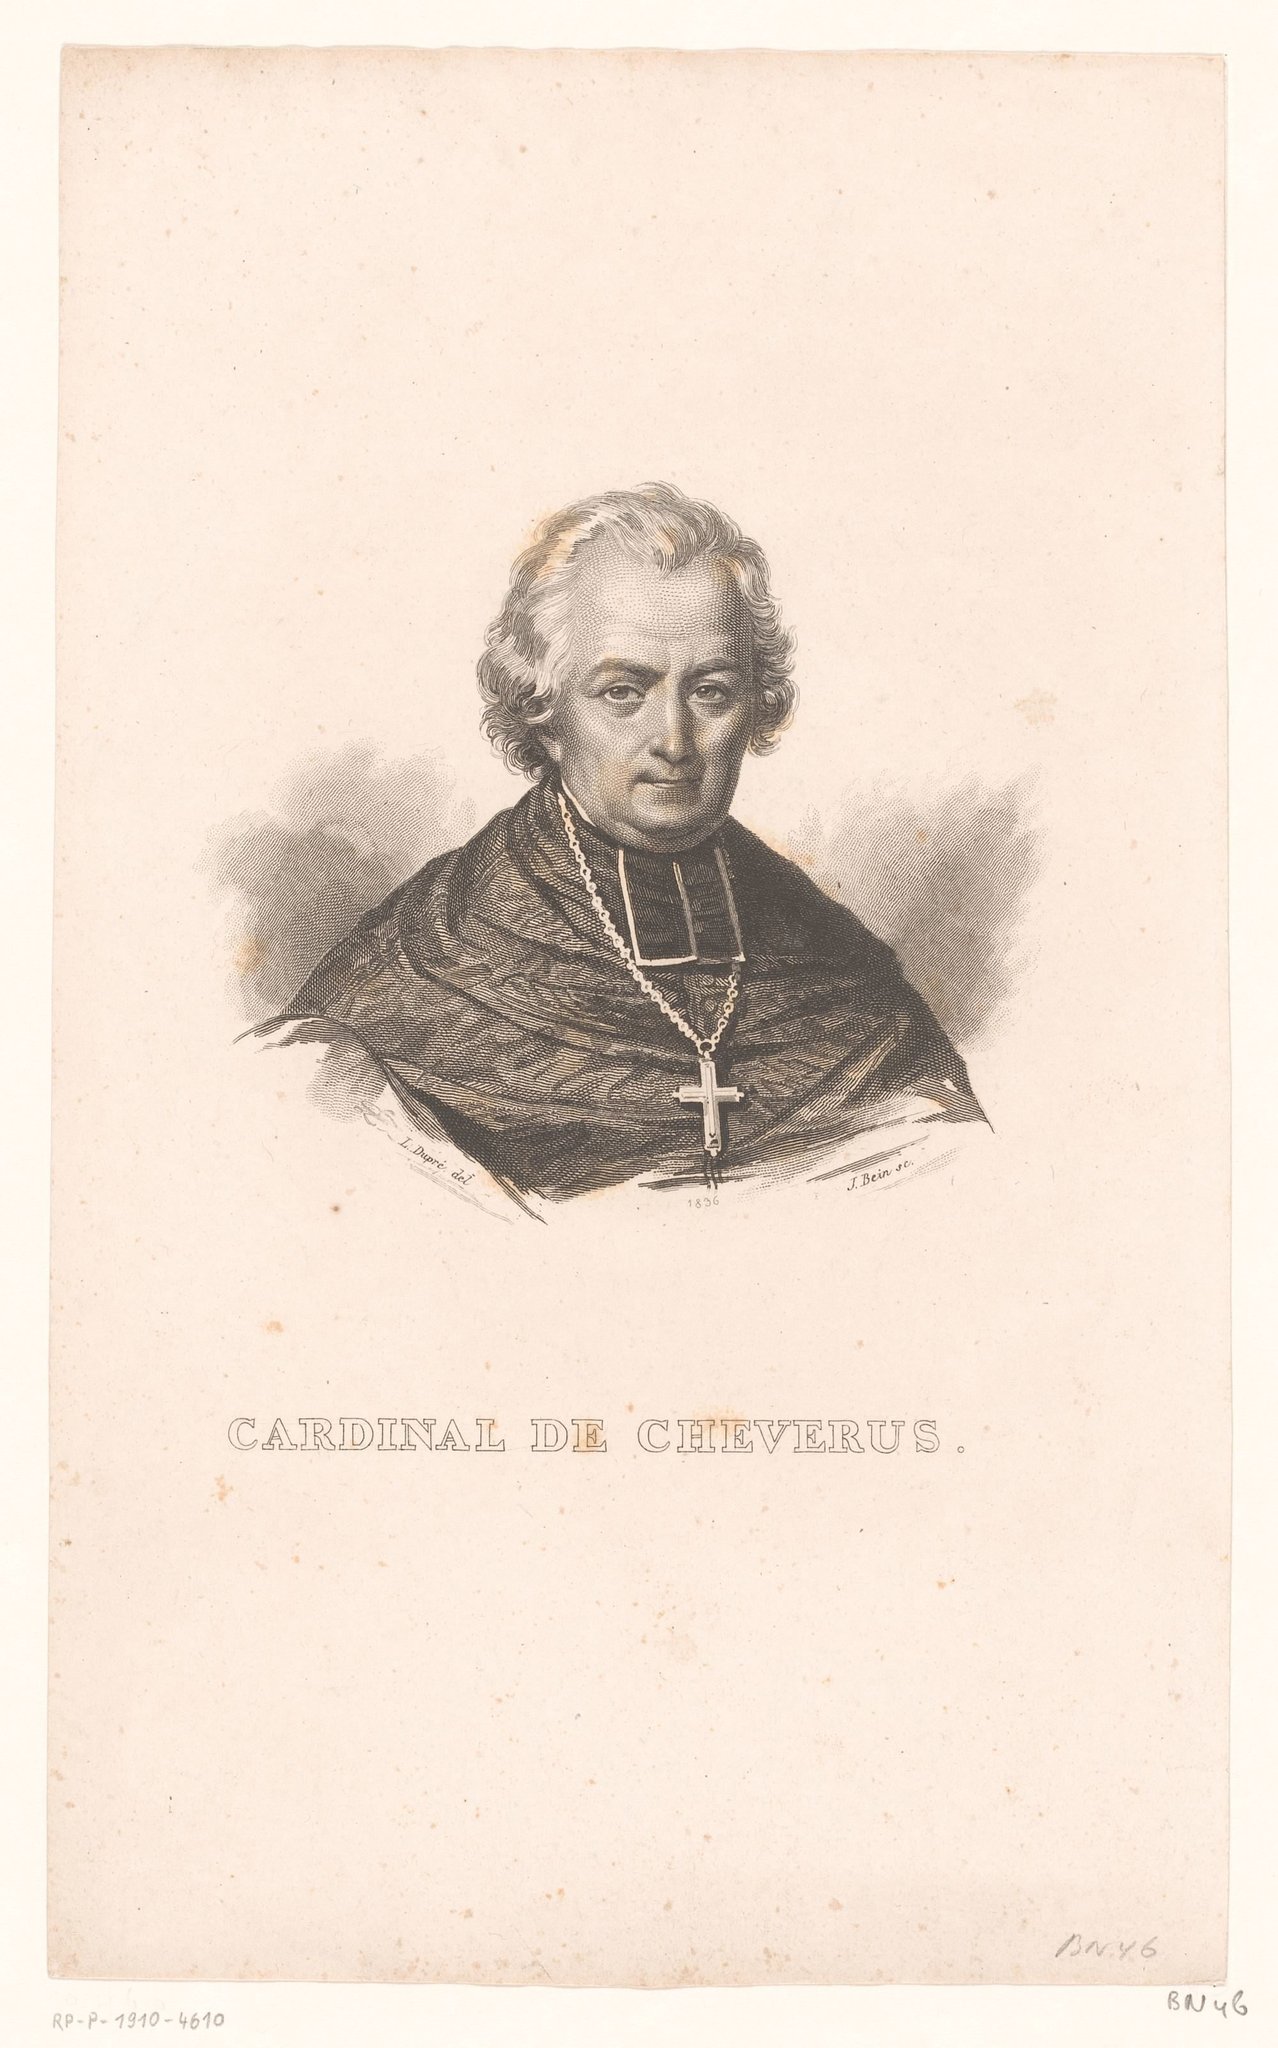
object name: print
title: Portret van Louise de La Vallière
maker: jean bein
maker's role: print maker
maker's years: 1789-1857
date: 1799-1857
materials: paper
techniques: engraving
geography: france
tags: ornament ~ medallion, historical persons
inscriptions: collector's mark: Lugt 2760